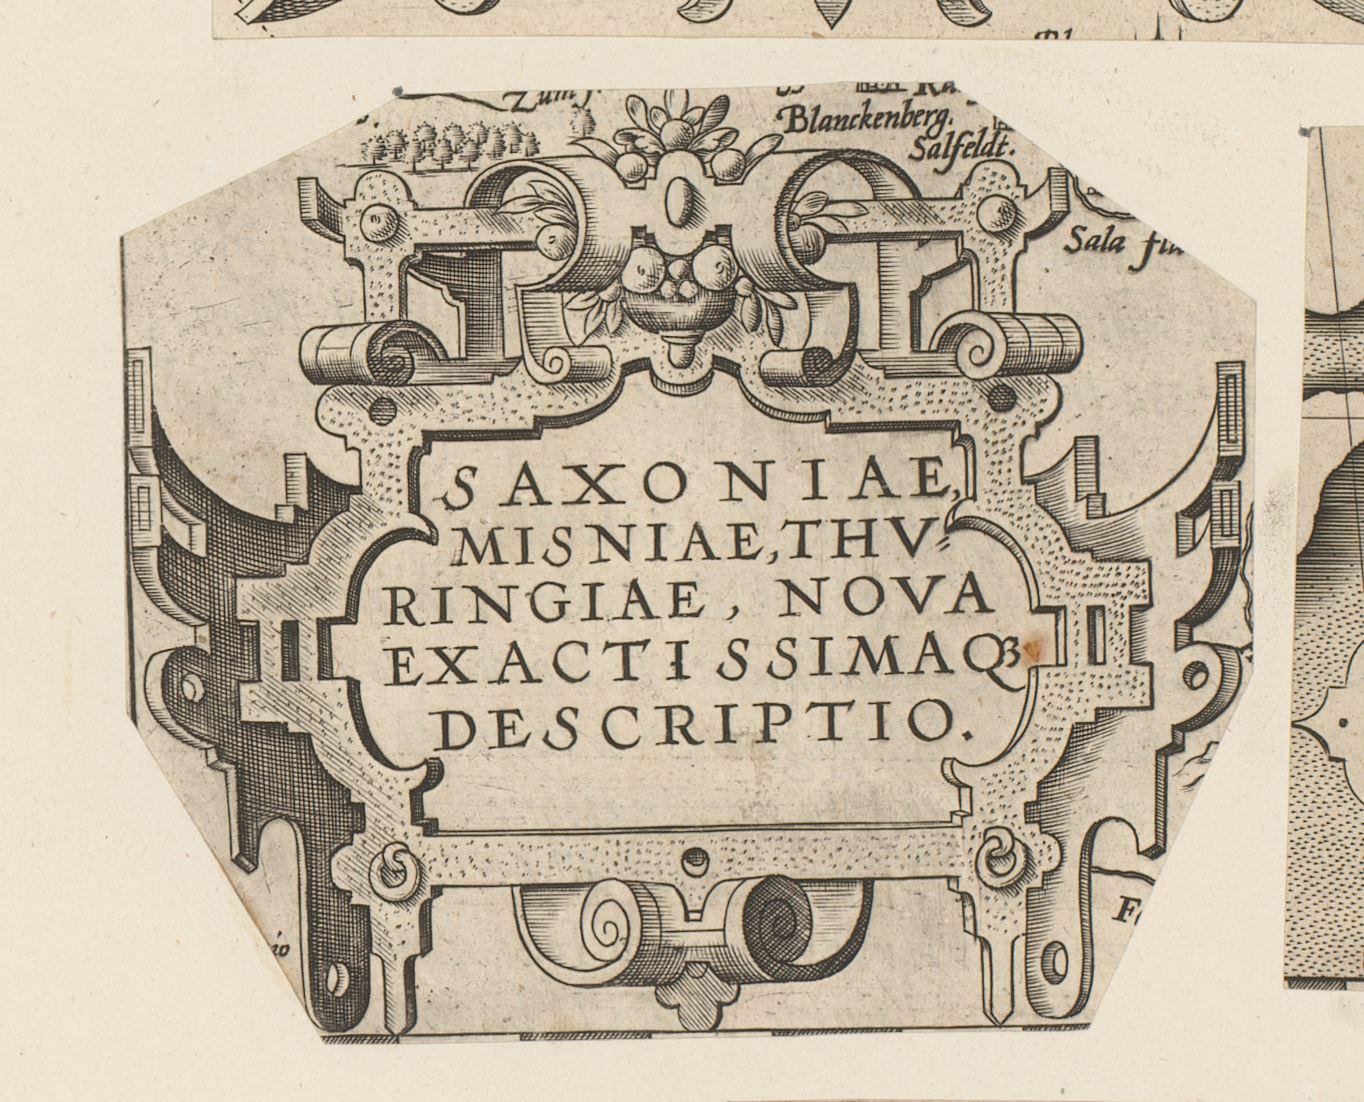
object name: album leaf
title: Cartouche van een kaart van Obersachsen, Meissen en Thüringen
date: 1570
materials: paper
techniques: engraving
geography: antwerp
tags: scrollwork, strapwork ~ ornament, ornament ~ cartouche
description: Cartouche met midden boven een vaas van rolwerk. Onderaan twee kettingringen. De cartouche is een fragment van een kaart van Obersachsen, Meissen en Thüringen. De prent maakt deel uit van een album.